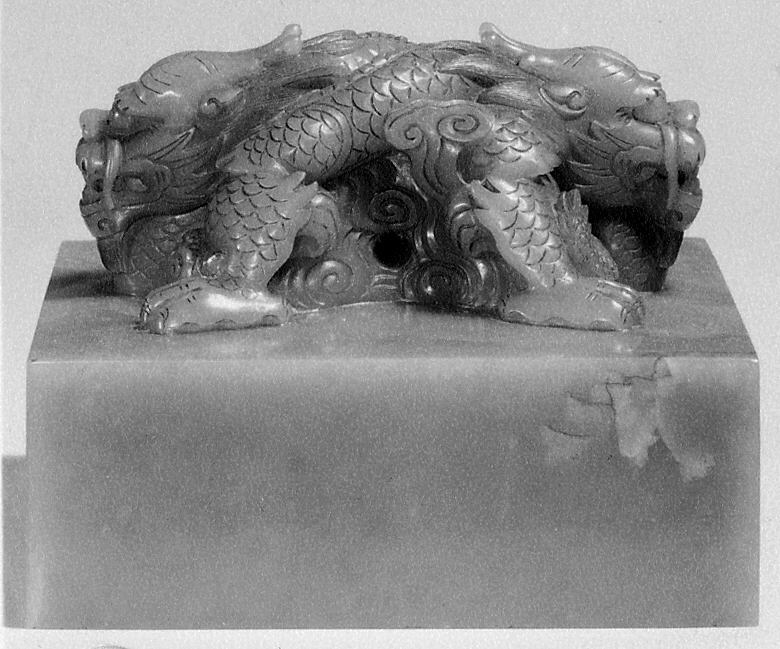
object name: seal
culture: chinese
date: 1701-1900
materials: jade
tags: dragons